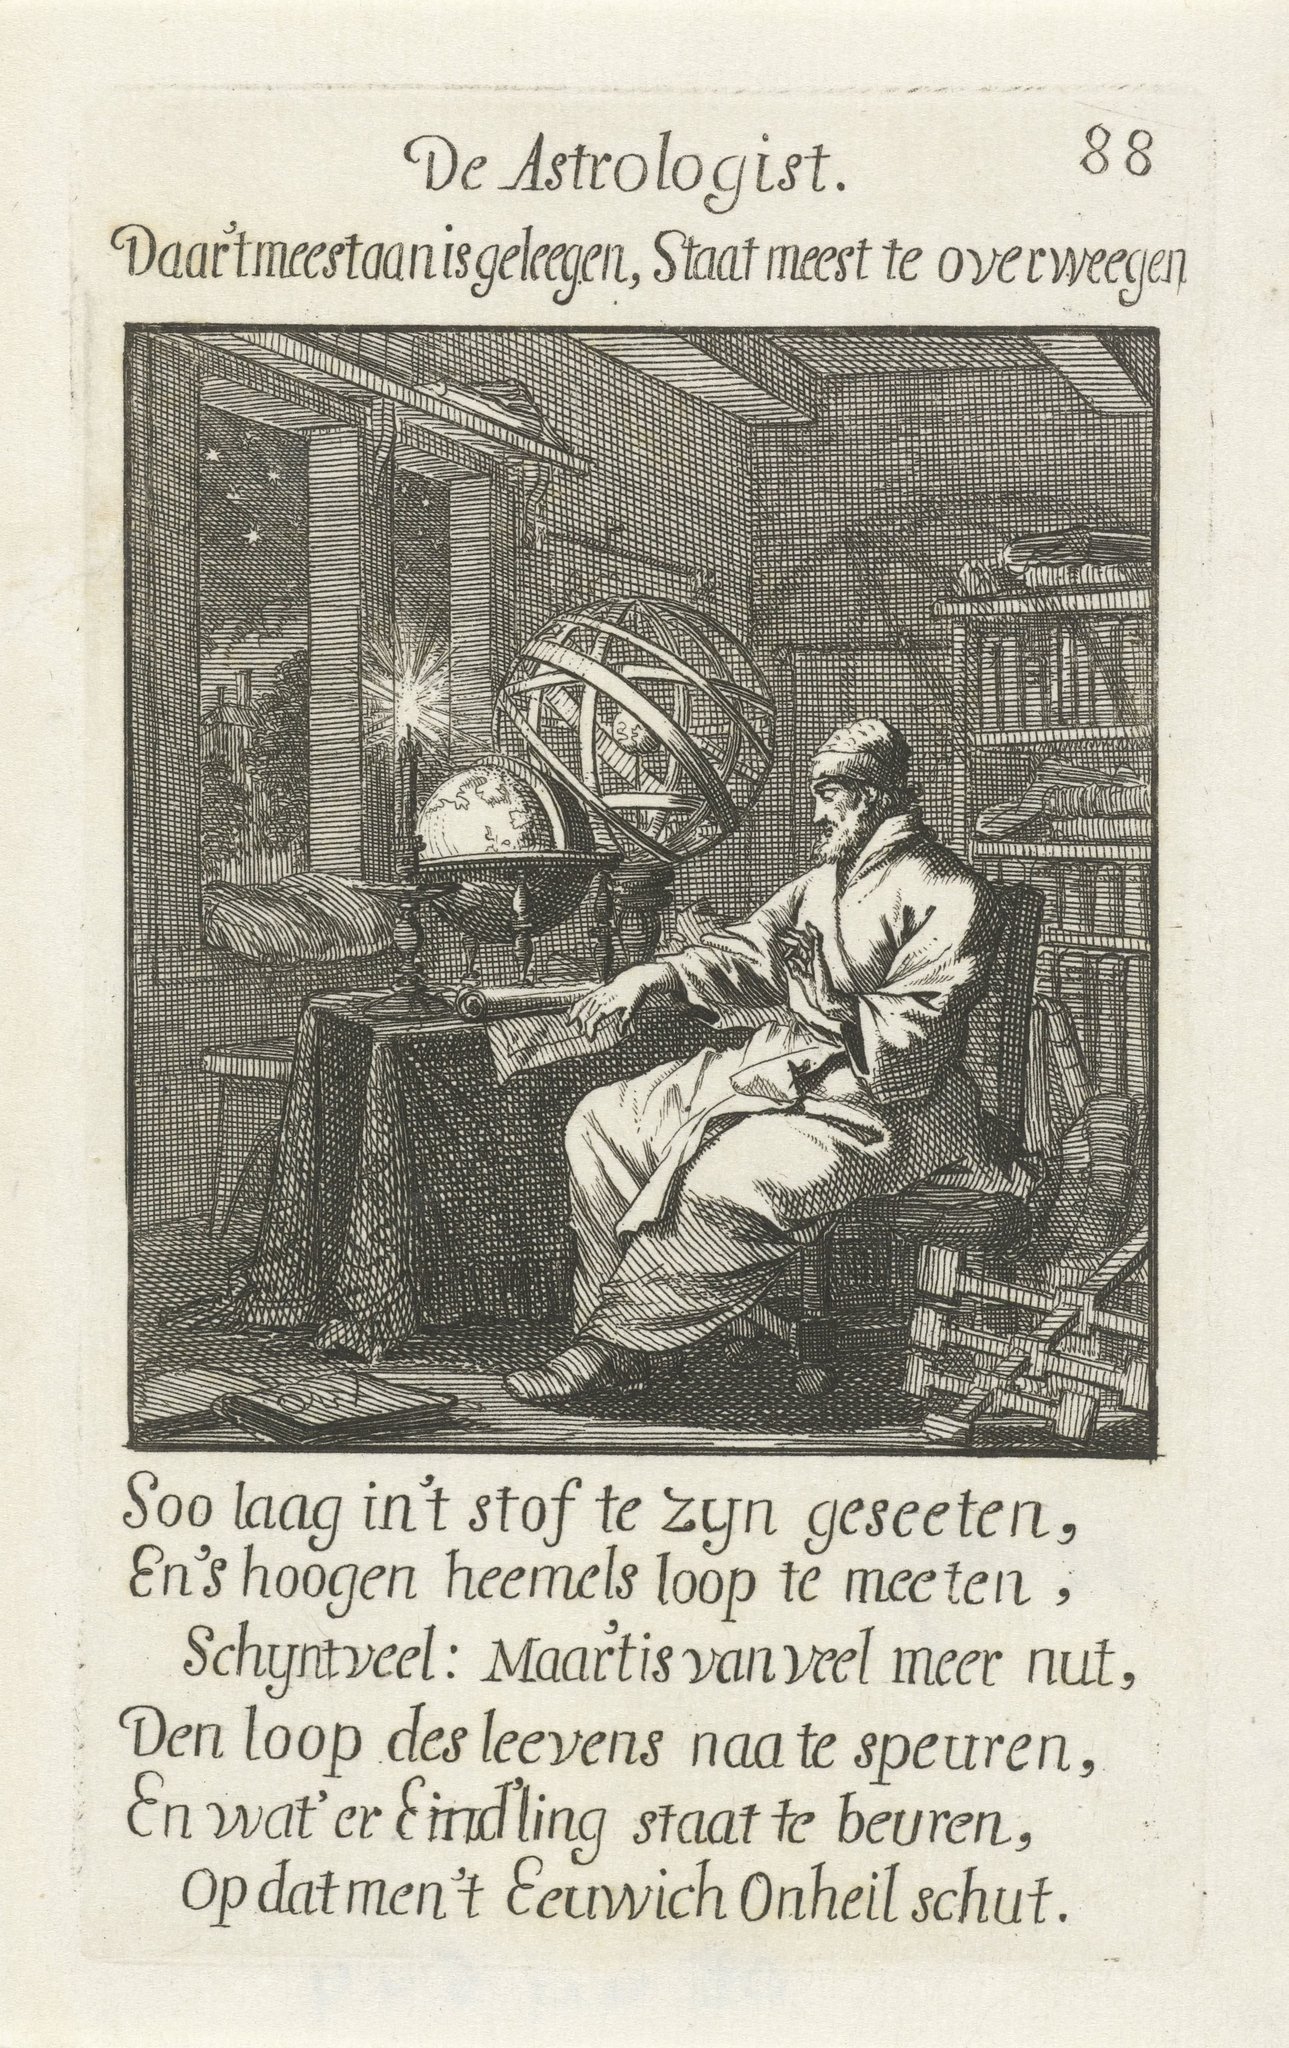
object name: print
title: Het Menselyk Bedryf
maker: jan luyken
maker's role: draughtsman, print maker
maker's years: 1649-1712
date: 1694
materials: paper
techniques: etching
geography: amsterdam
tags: astrologer at work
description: Maakt deel uit van de 100-delige serie beroepsprenten van Jan en Caspar Luyken, getiteld: Het menselyk bedryf. S.l.s.n., 1694 (eerste druk).